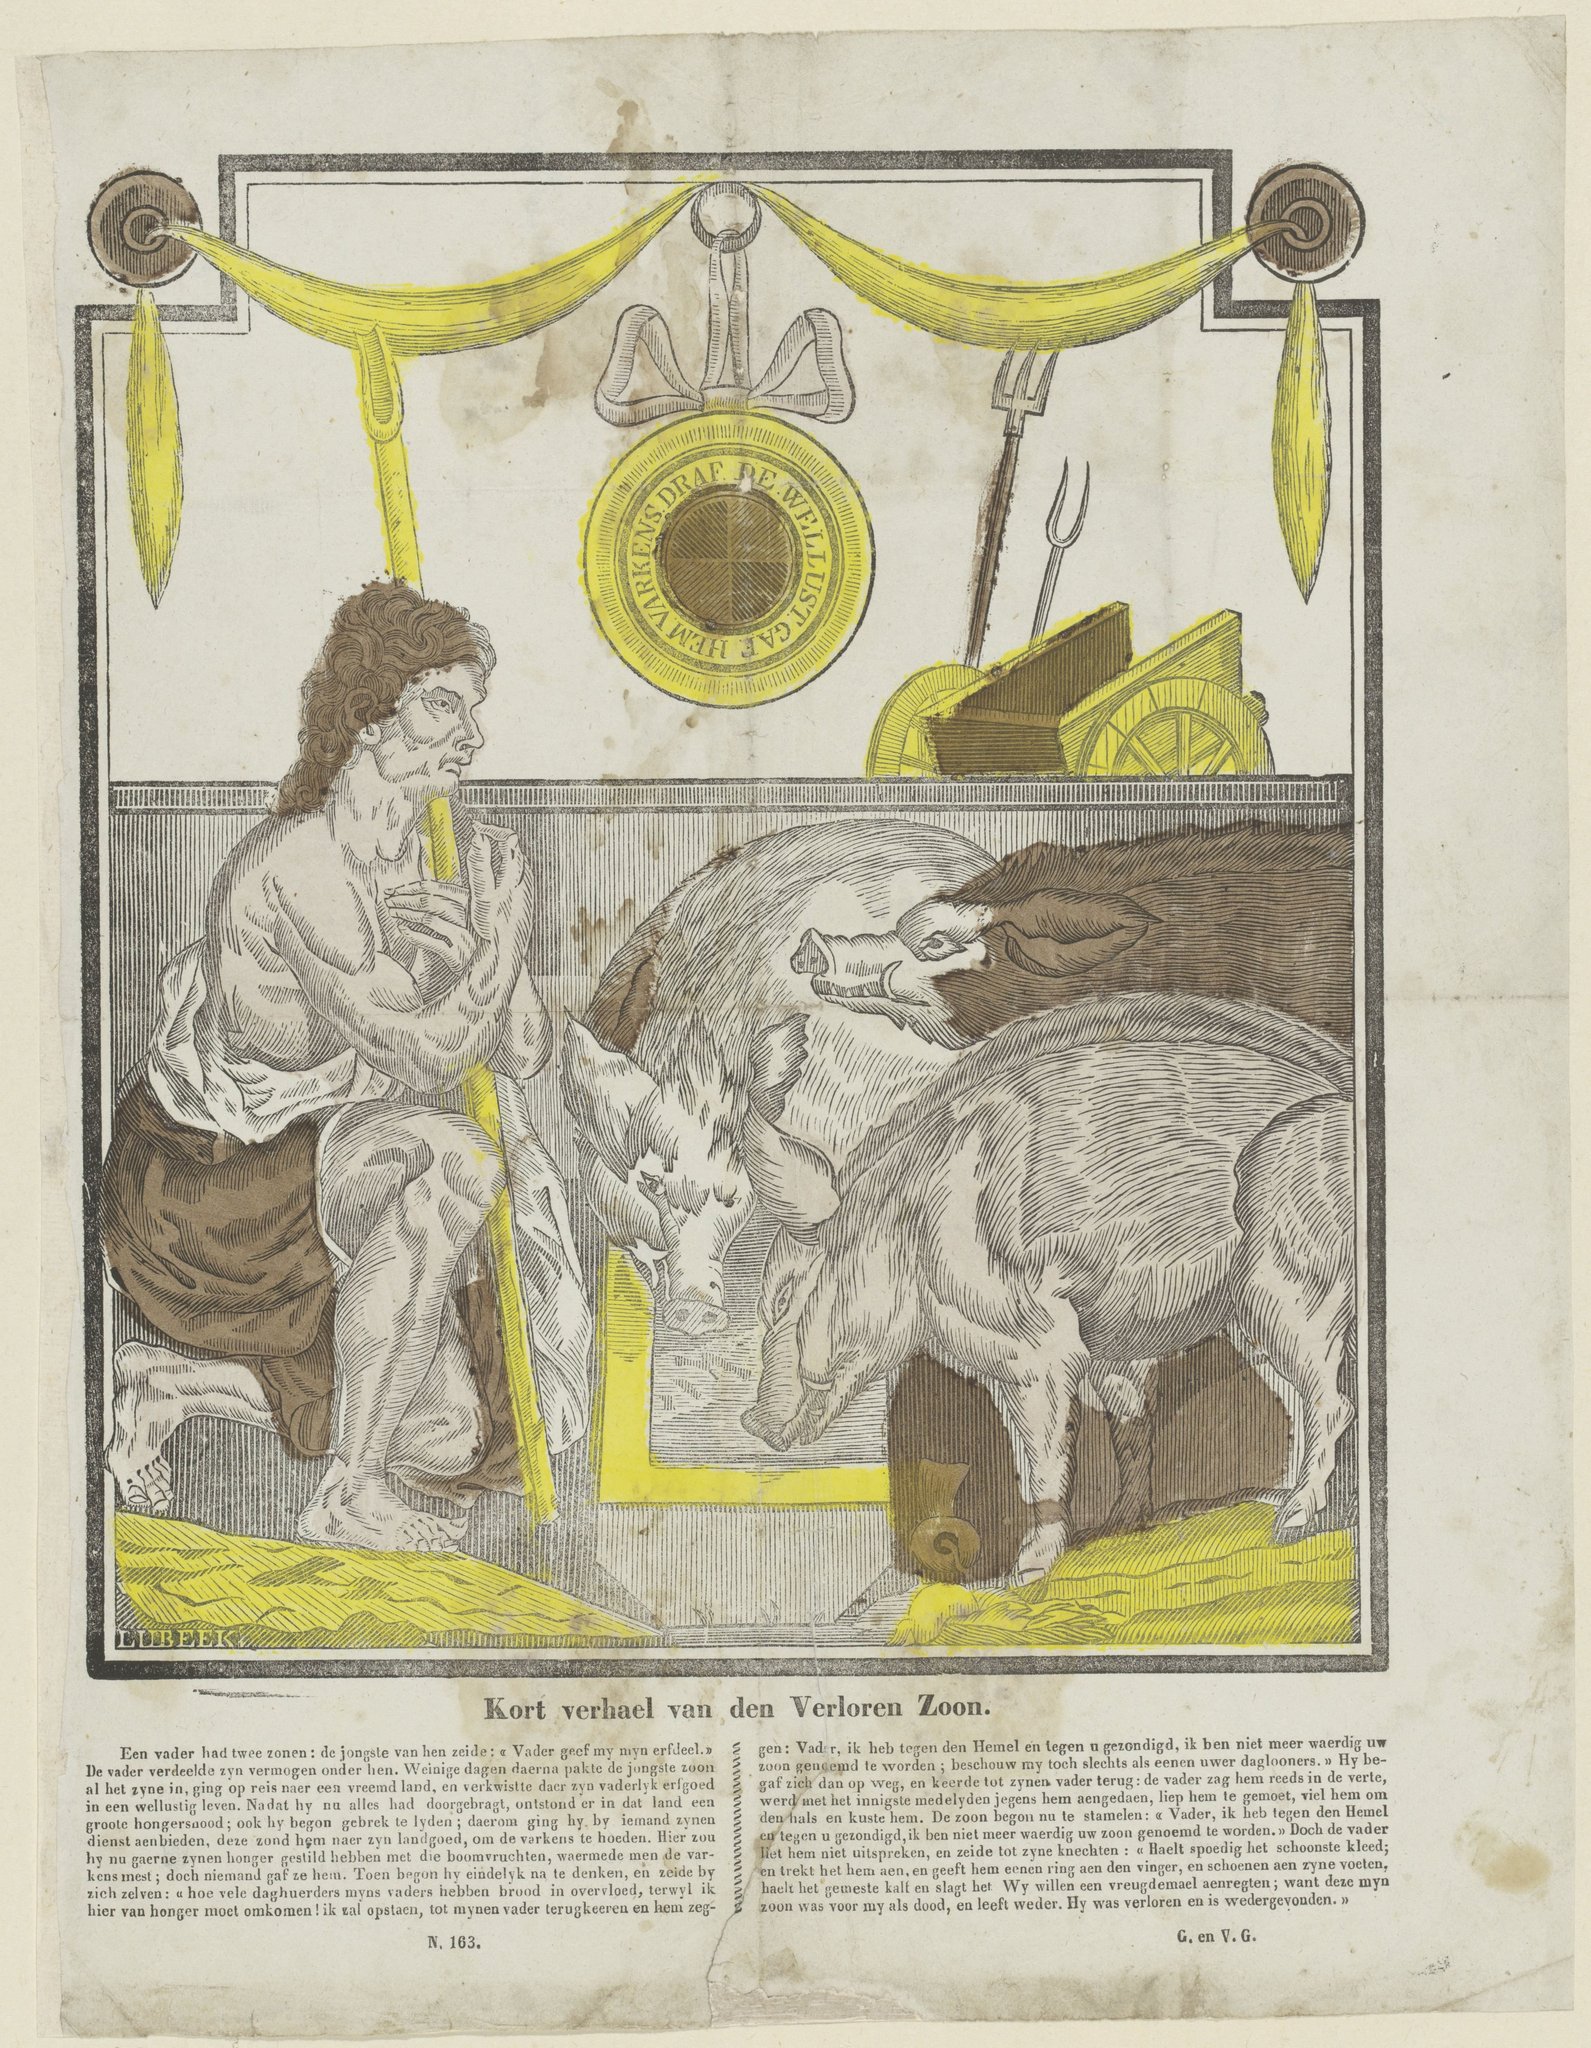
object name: print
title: Kort verhael van den Verloren Zoon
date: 1833-1856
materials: paper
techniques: colour, letterpress printing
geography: turnhout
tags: the parable of the prodigal son (luke 15:11-32)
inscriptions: collector's mark: Lugt 2760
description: Blad met een grote voorstelling uit het verhaal van de verloren zoon. De verloren zoon zit geknield in een stal met drie zwijnen. Onder de voorstelling een onderschrift in twee kolommen. Genummerd linksonder: N. 163.